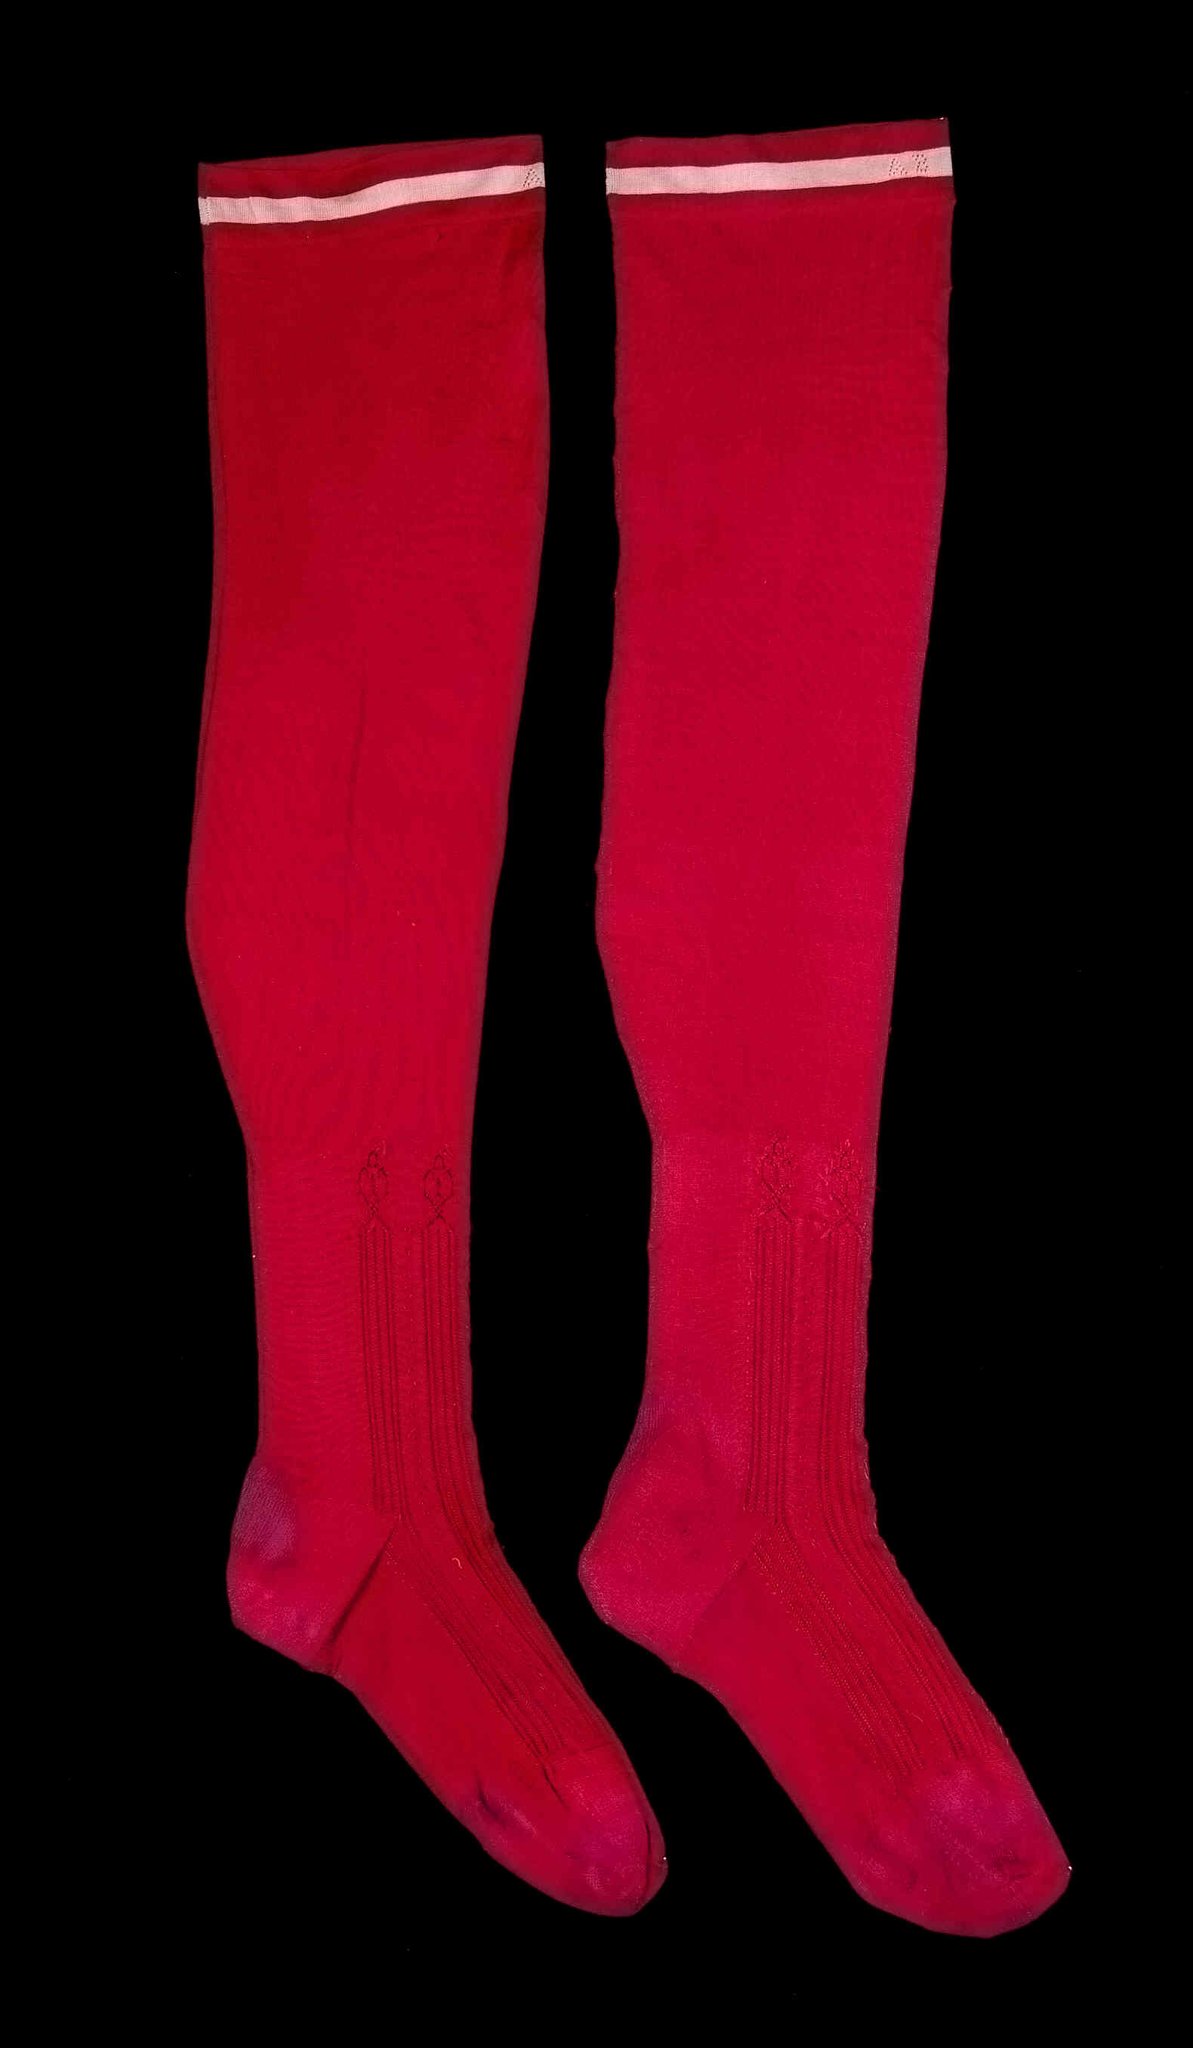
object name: stocking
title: Stockings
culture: american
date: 1870-1890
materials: silk